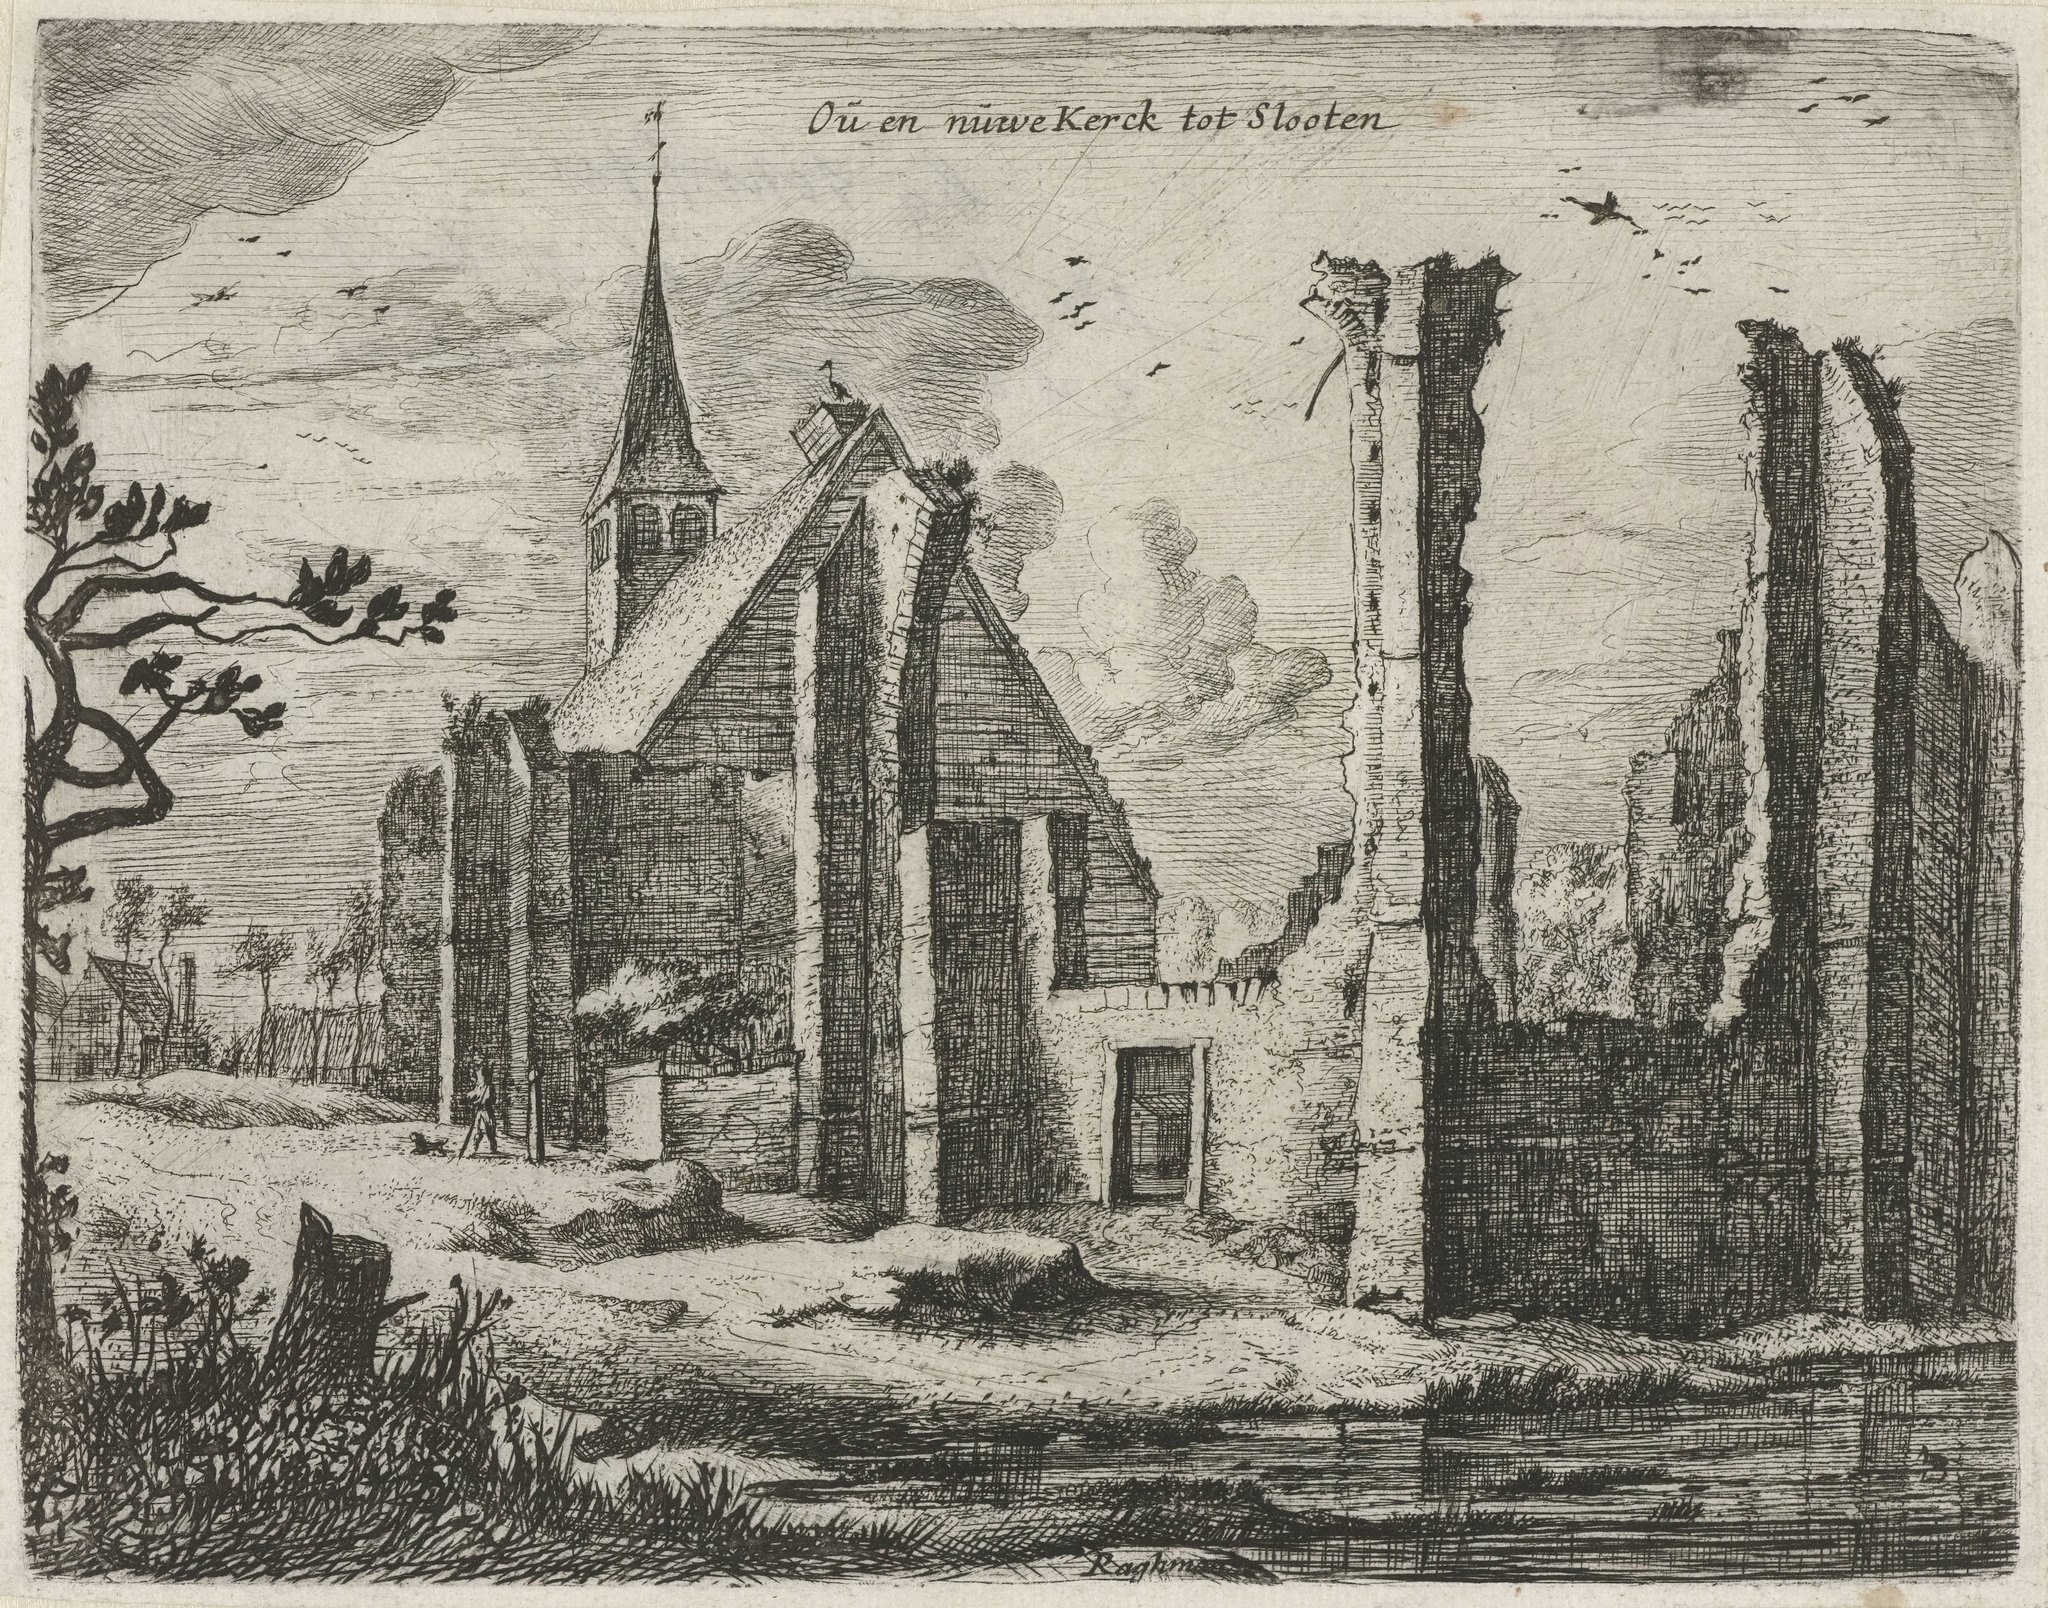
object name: print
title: Landschappen in de provincies Holland en Utrecht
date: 1637-1677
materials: paper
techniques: etching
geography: amsterdam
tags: shore-birds and wading-birds: stork, church (exterior), ruin of church, monastery, etc.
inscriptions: collector's mark: Lugt 2228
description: Gezicht op het geruïneerde koor van de oude kerk te Sloten met daarachter de nieuwe kerk. Op het dak van de nieuwe kerk een ooievaarsnest. Op de voorgrond een waterplas.